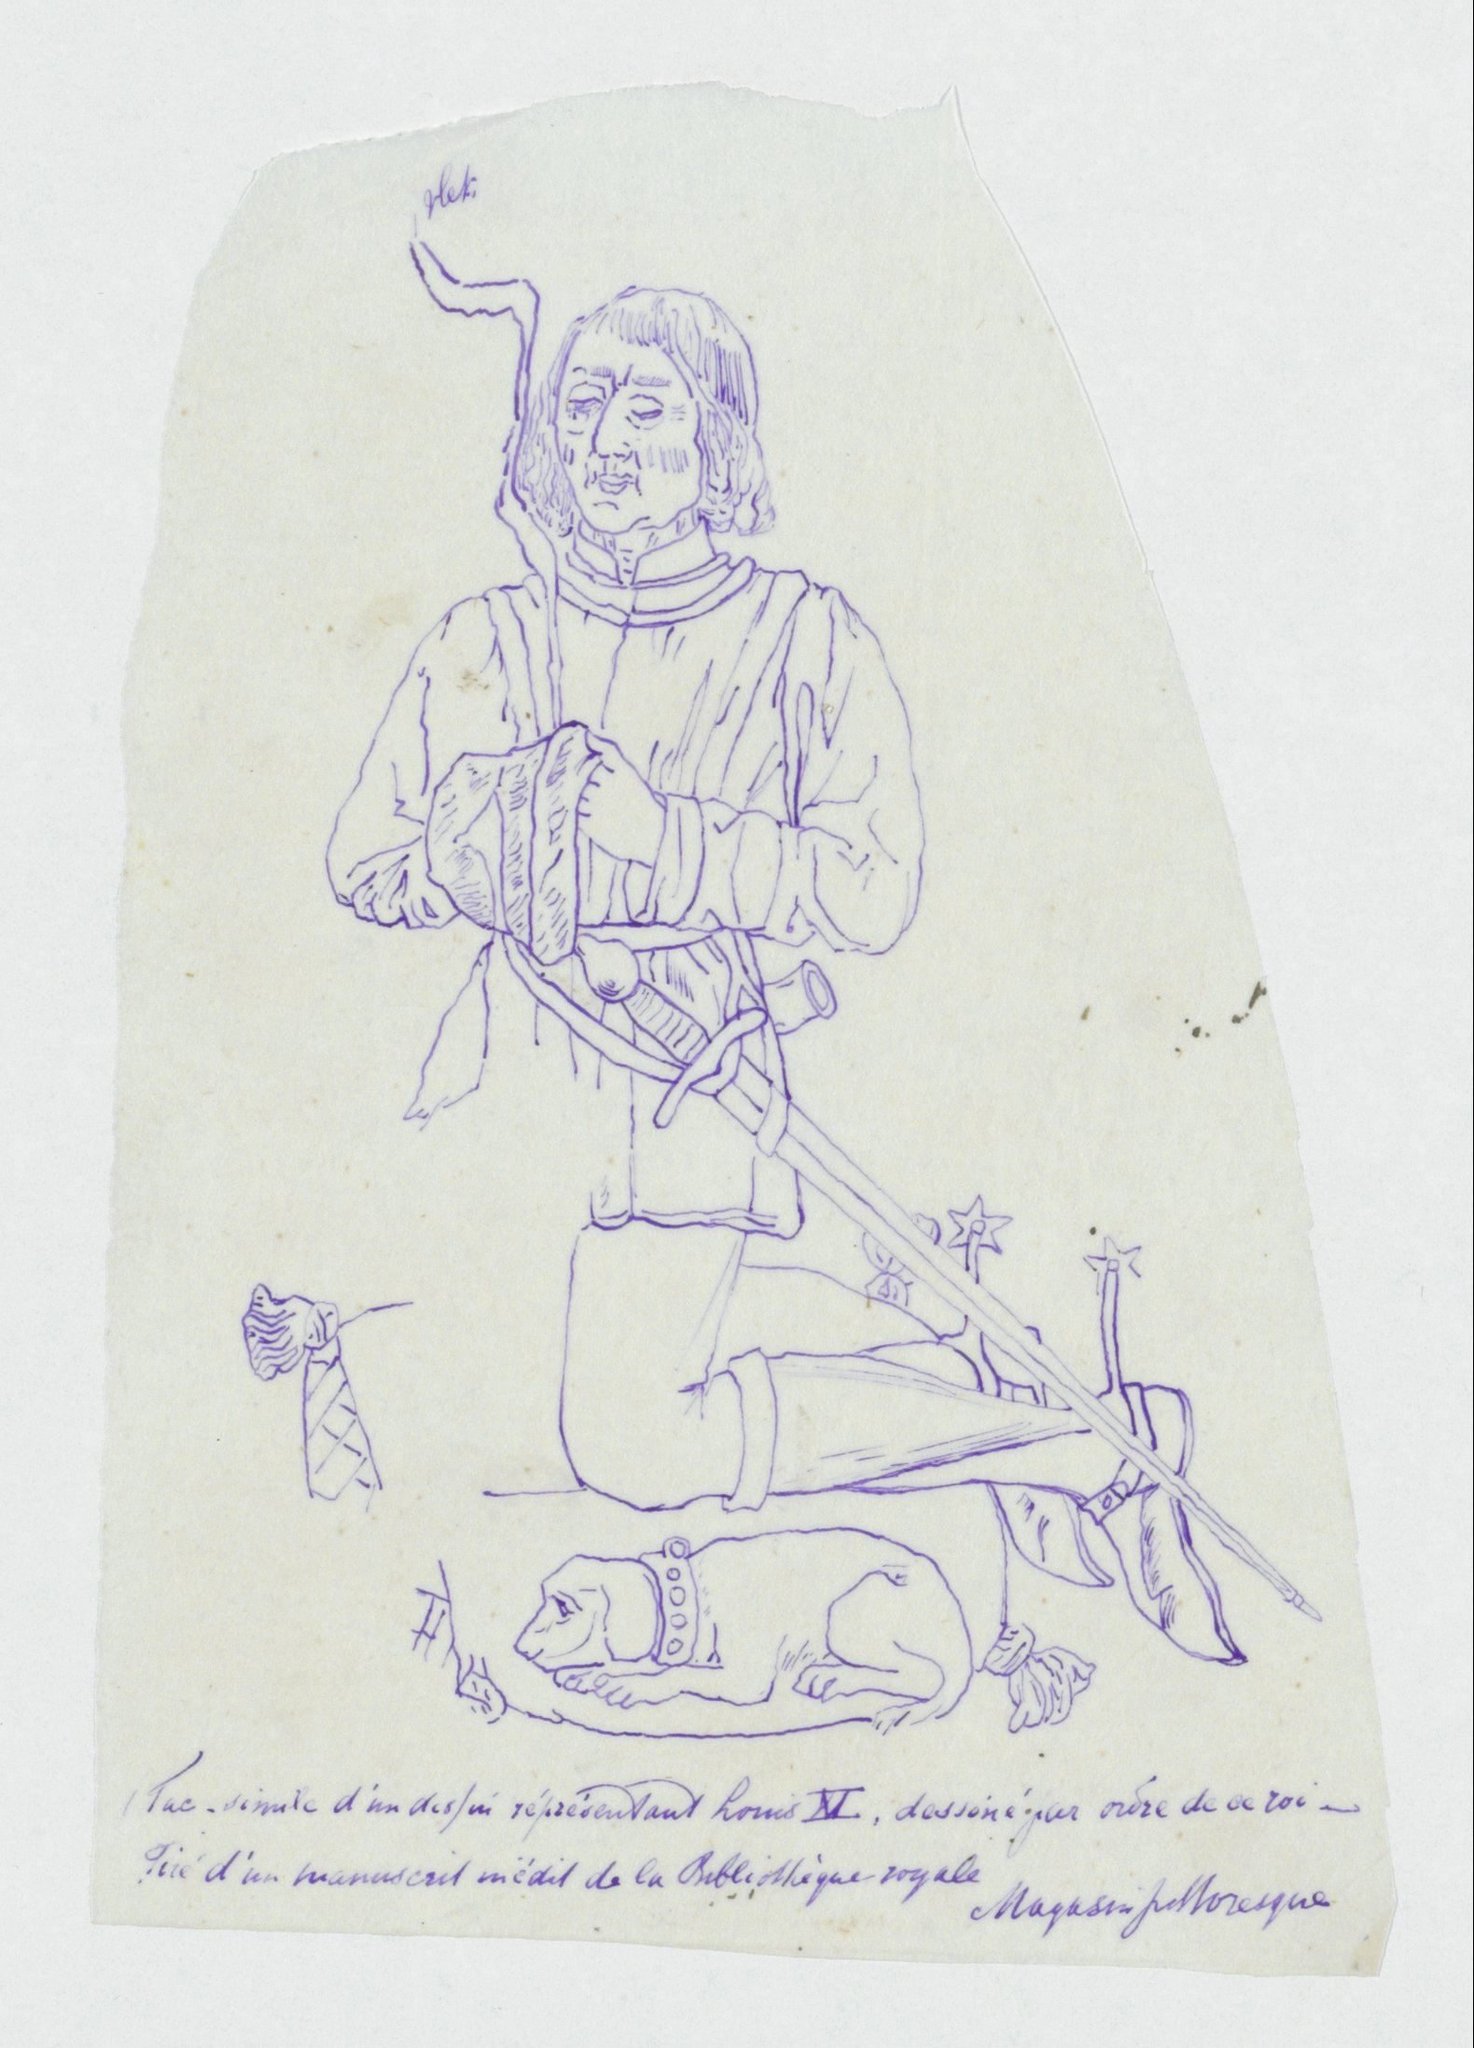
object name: drawing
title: Knielende Lodewijk XI van Frankrijk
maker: jan veth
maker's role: designer, draughtsman, painter, print maker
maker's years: 1864-1925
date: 1874-1925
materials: ink, paper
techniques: pen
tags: kneeling figure, dog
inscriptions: annotation: ‘Hek/ Fac-simule d'un dessin réprésentant Louis XI, dessiné sur ordre de ce roi-/ Prie d'un manuscrit médit de la Bibliotheque royale/ Magasin Pittoresque’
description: De tekening is overgetrokken uit de publicatie 'Magazin Pittoresque'. De losse tekening komt uit een blauwe map met een deel van een schetsboek met 4 bladen, vier losse tekeningen en twee stuks drukwerk.